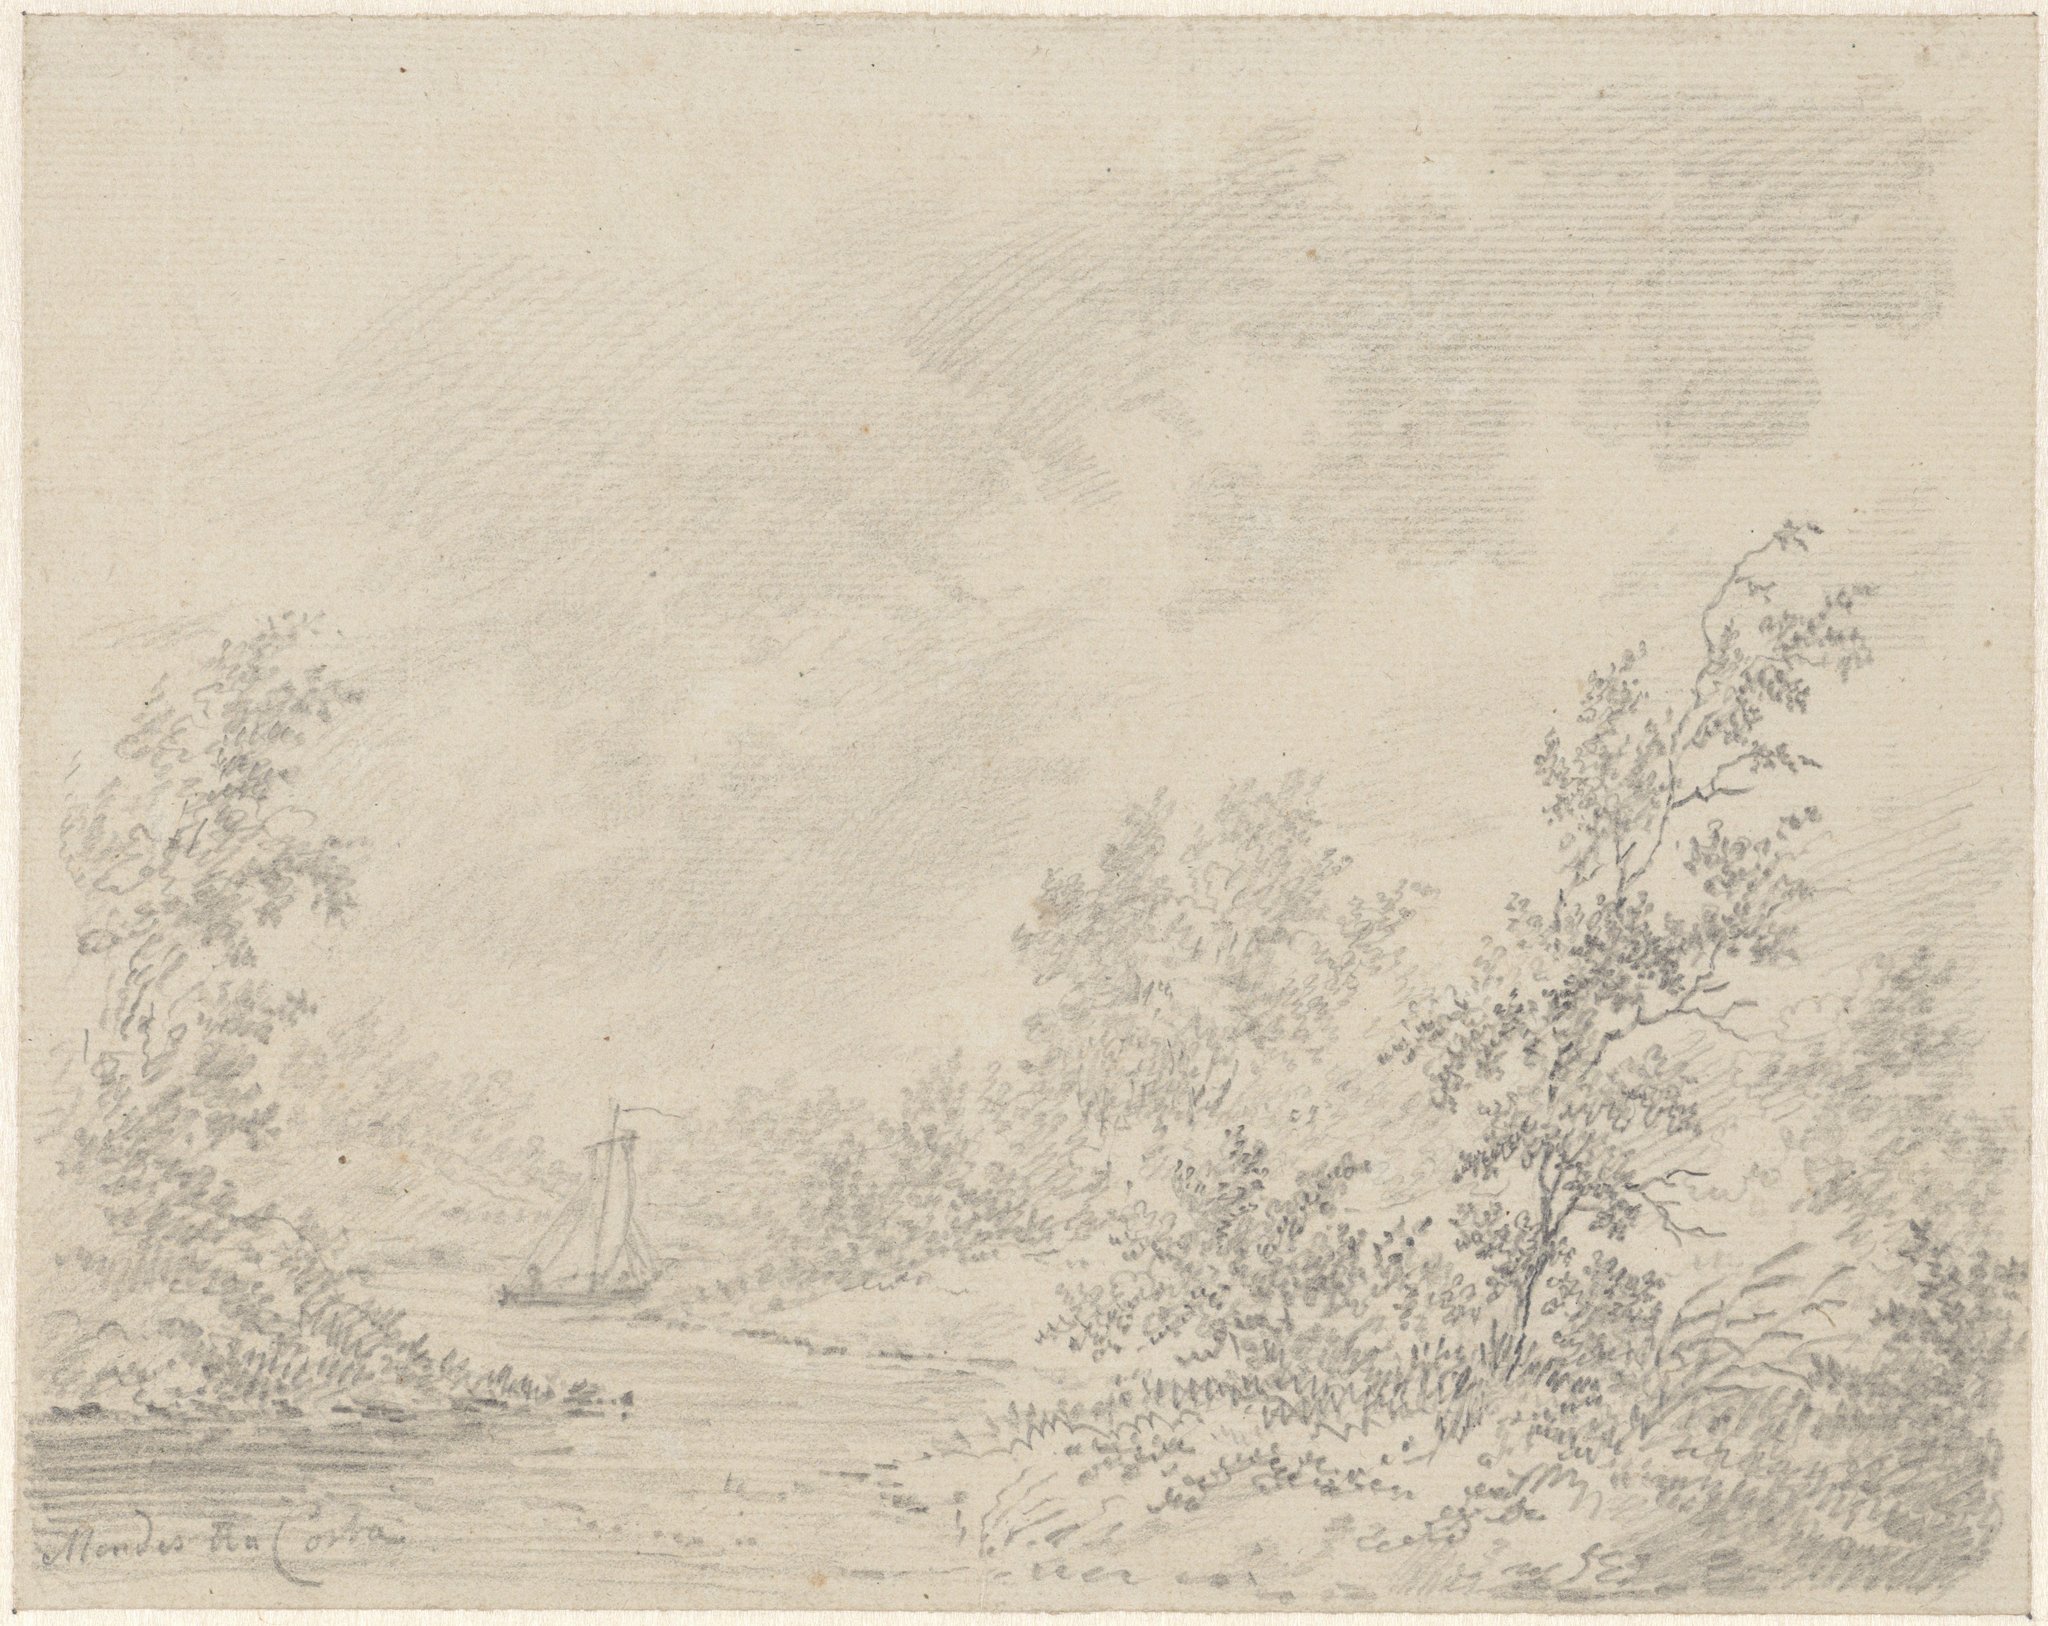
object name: drawing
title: Rivierlandschap met zeilbootje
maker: samuel henri mendes da costa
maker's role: draughtsman, print maker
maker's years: 1845-1923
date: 1855-1923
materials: paper, pencil